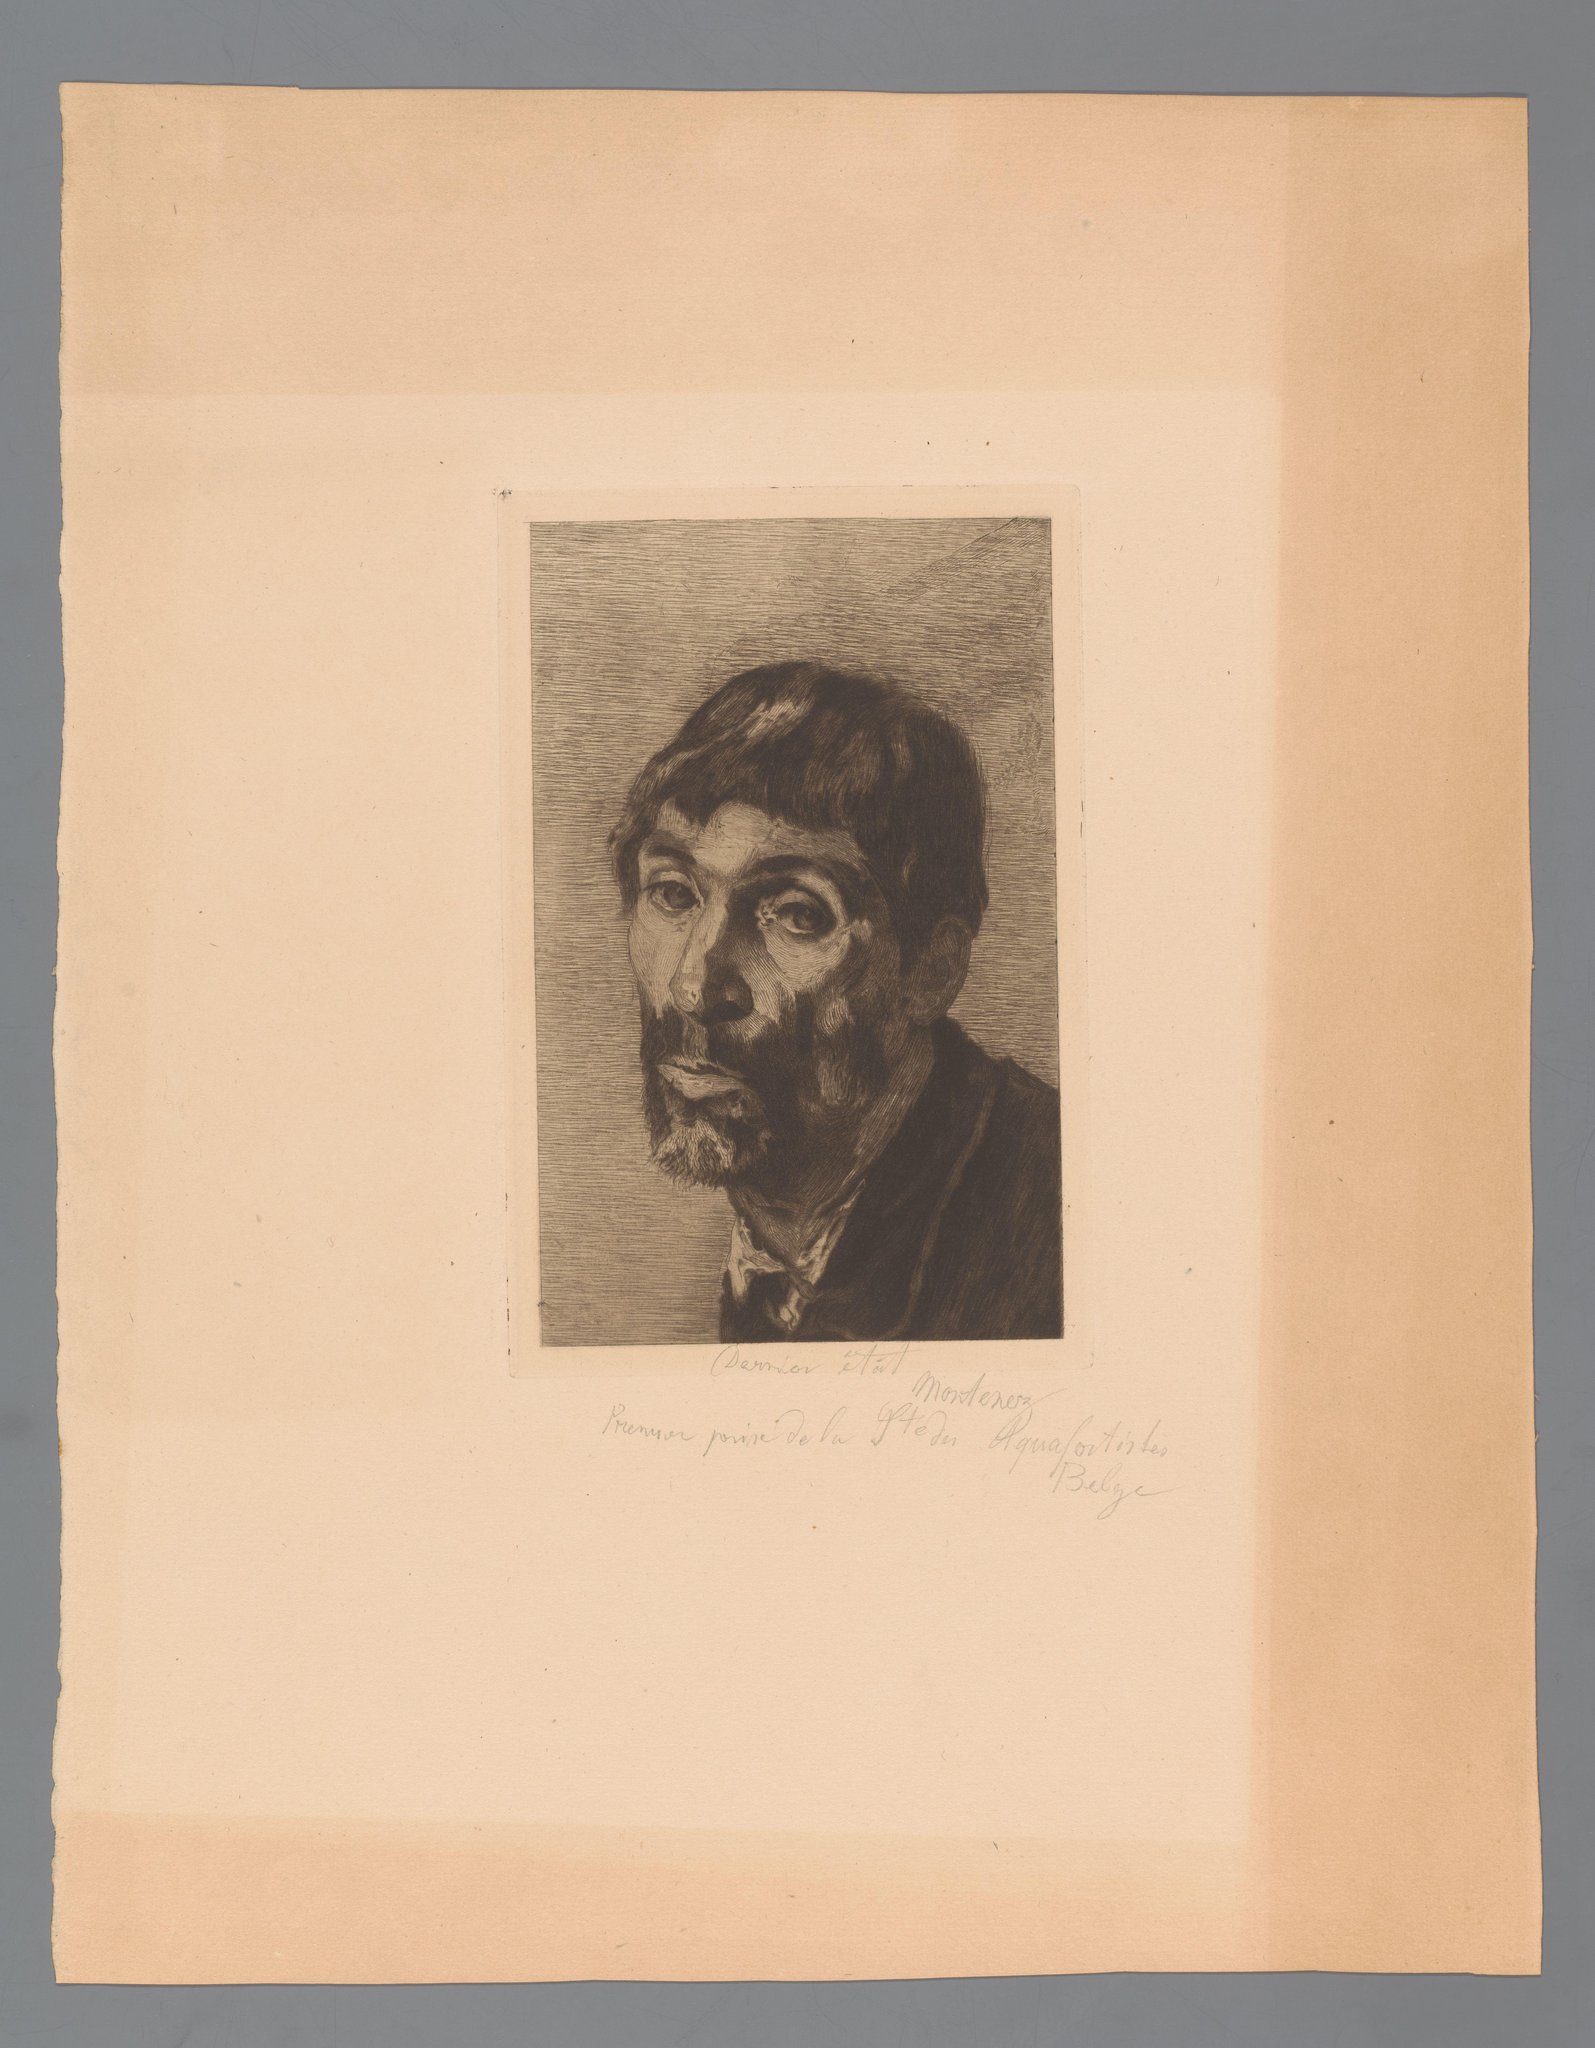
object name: print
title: Hoofd van een onbekende man, mogelijk een bedelaar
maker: georges montenez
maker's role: print maker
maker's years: 1873-1930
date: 1883-1913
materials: paper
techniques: drypoint, etching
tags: adult man, beggar, beard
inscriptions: inscription: ‘Derrion état; Premier prise de la Ste de Aquafortistes Belge’, collector's mark: Lugt 2228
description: In de inventaris getiteld: De bedelaar naar Wauters.